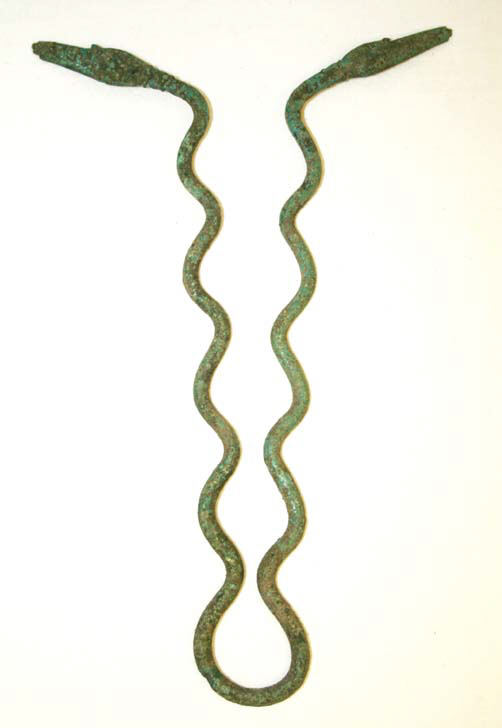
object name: pin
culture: european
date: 400-301 BCE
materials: bronze